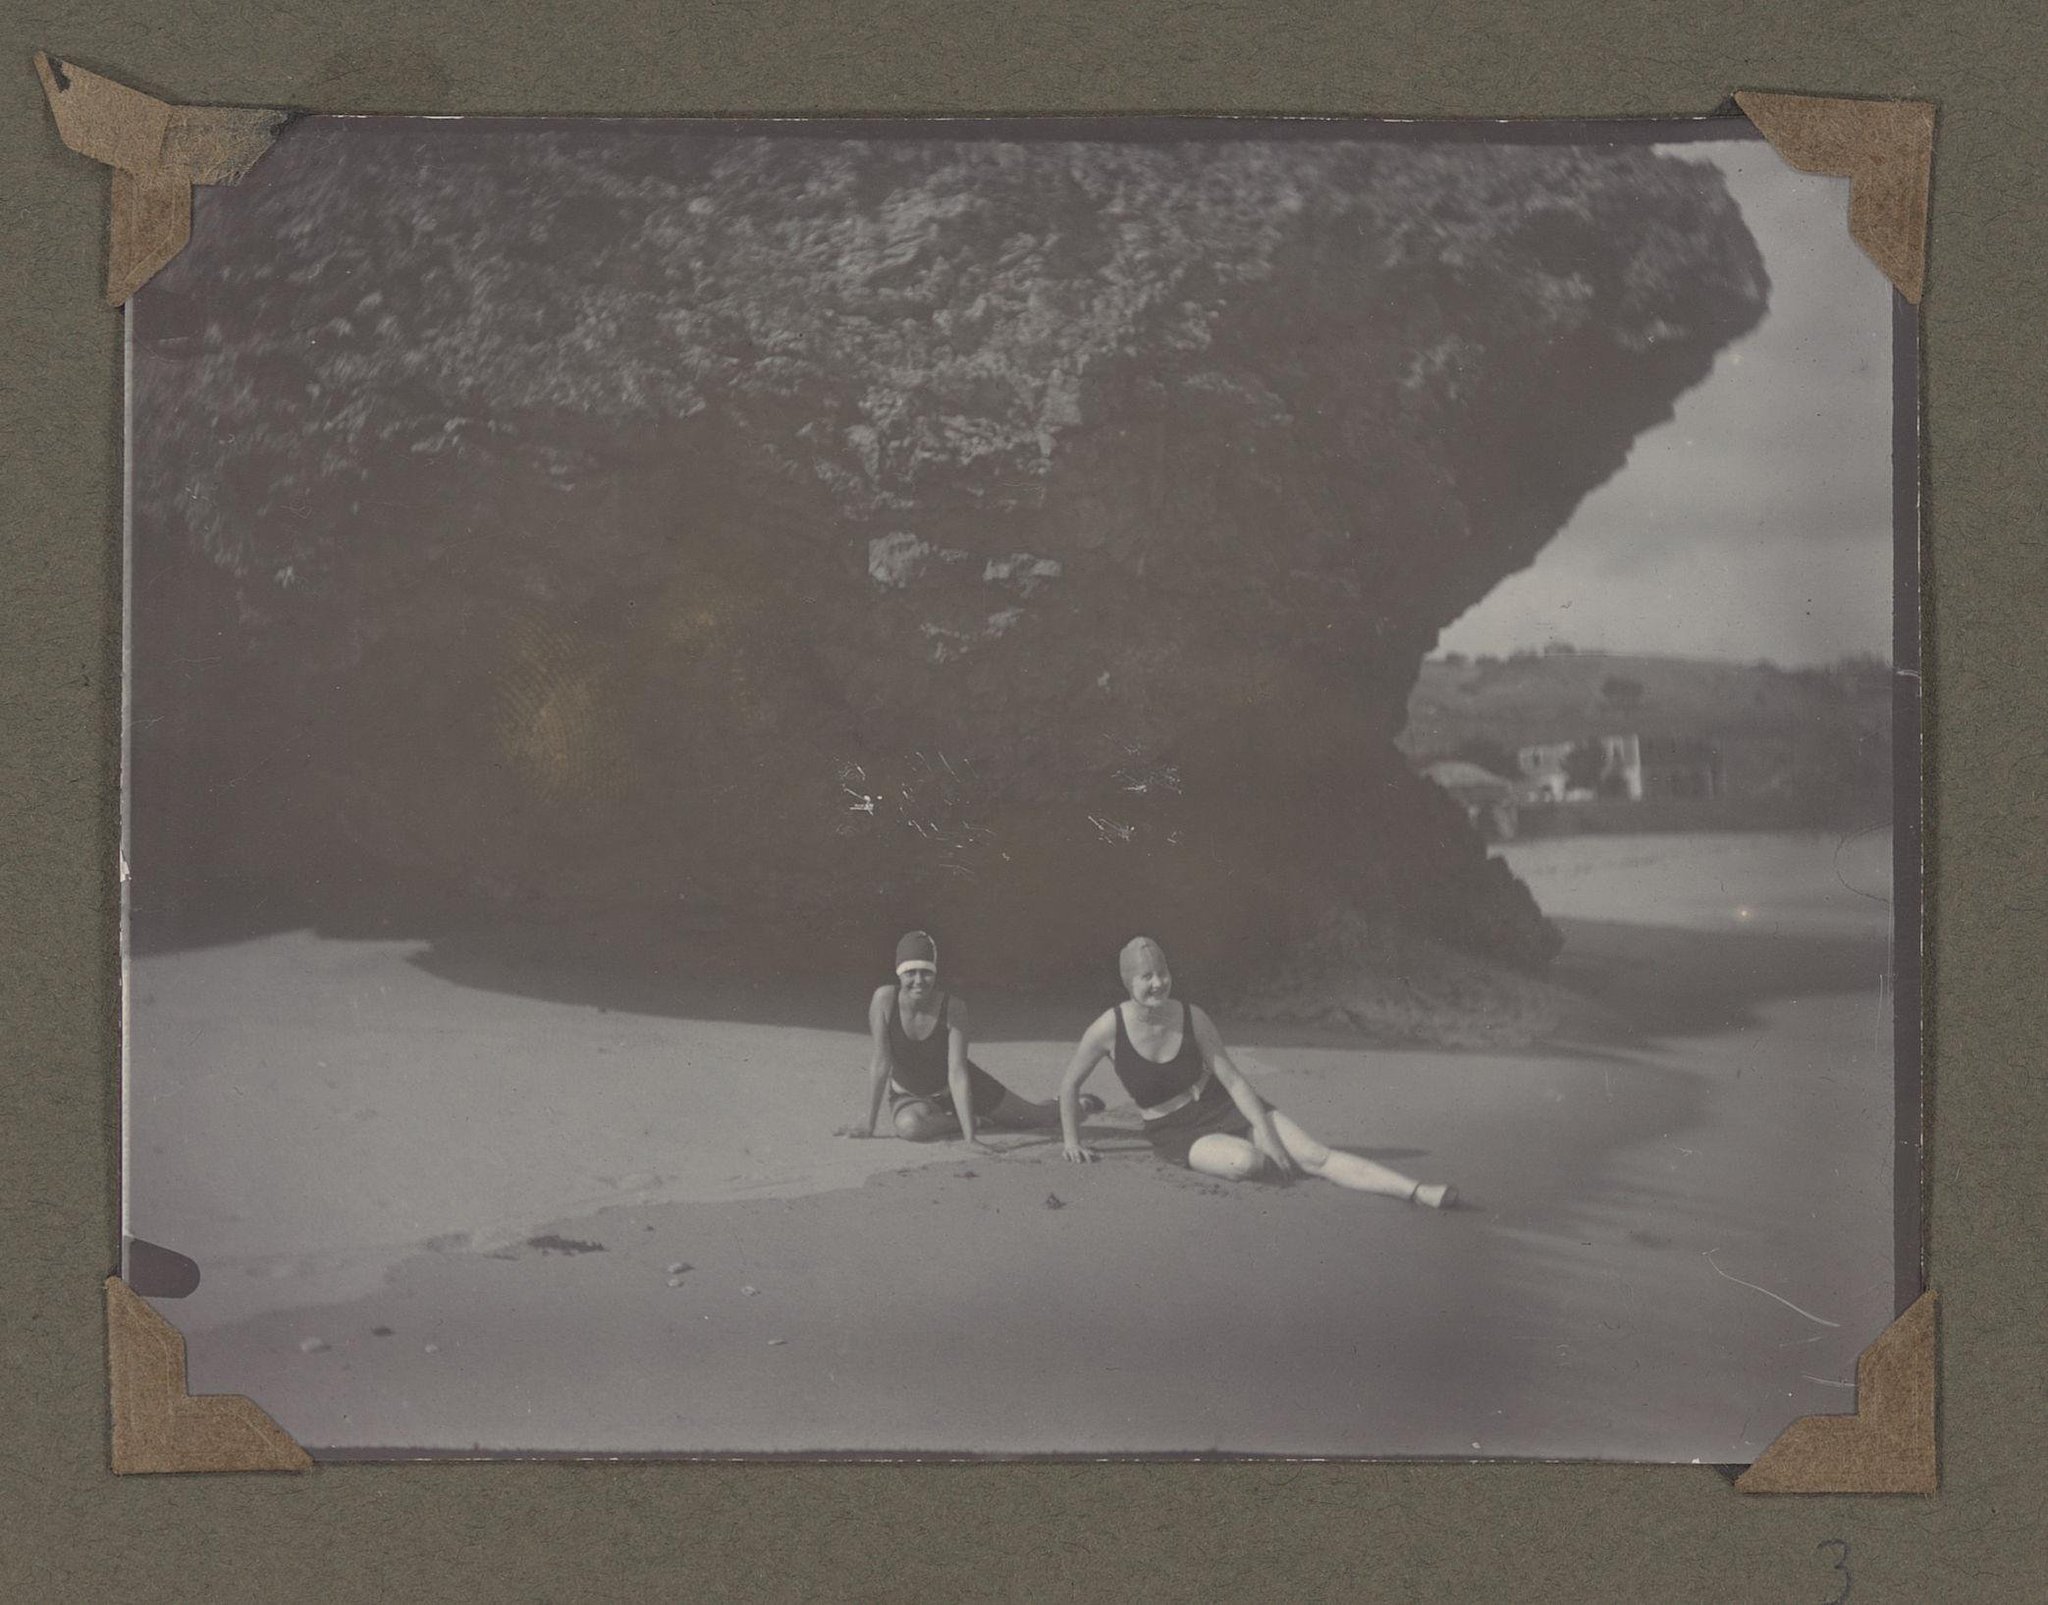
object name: photograph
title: Familiefoto van de vakantie op Barbados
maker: Anonymous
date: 1925-1927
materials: photographic support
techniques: photography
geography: suriname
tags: jetten, familie, moengo, barbados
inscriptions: inscription: ‘Barbedos’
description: Familiefoto van het gezin Jetten op vakantie in Barbados. Foto op een bladzijde van een los albumblad. Onderdeel van het ensemble met foto's van de familie van ingenieur Jetten in de mijnbouwstad Moengo in Suriname.